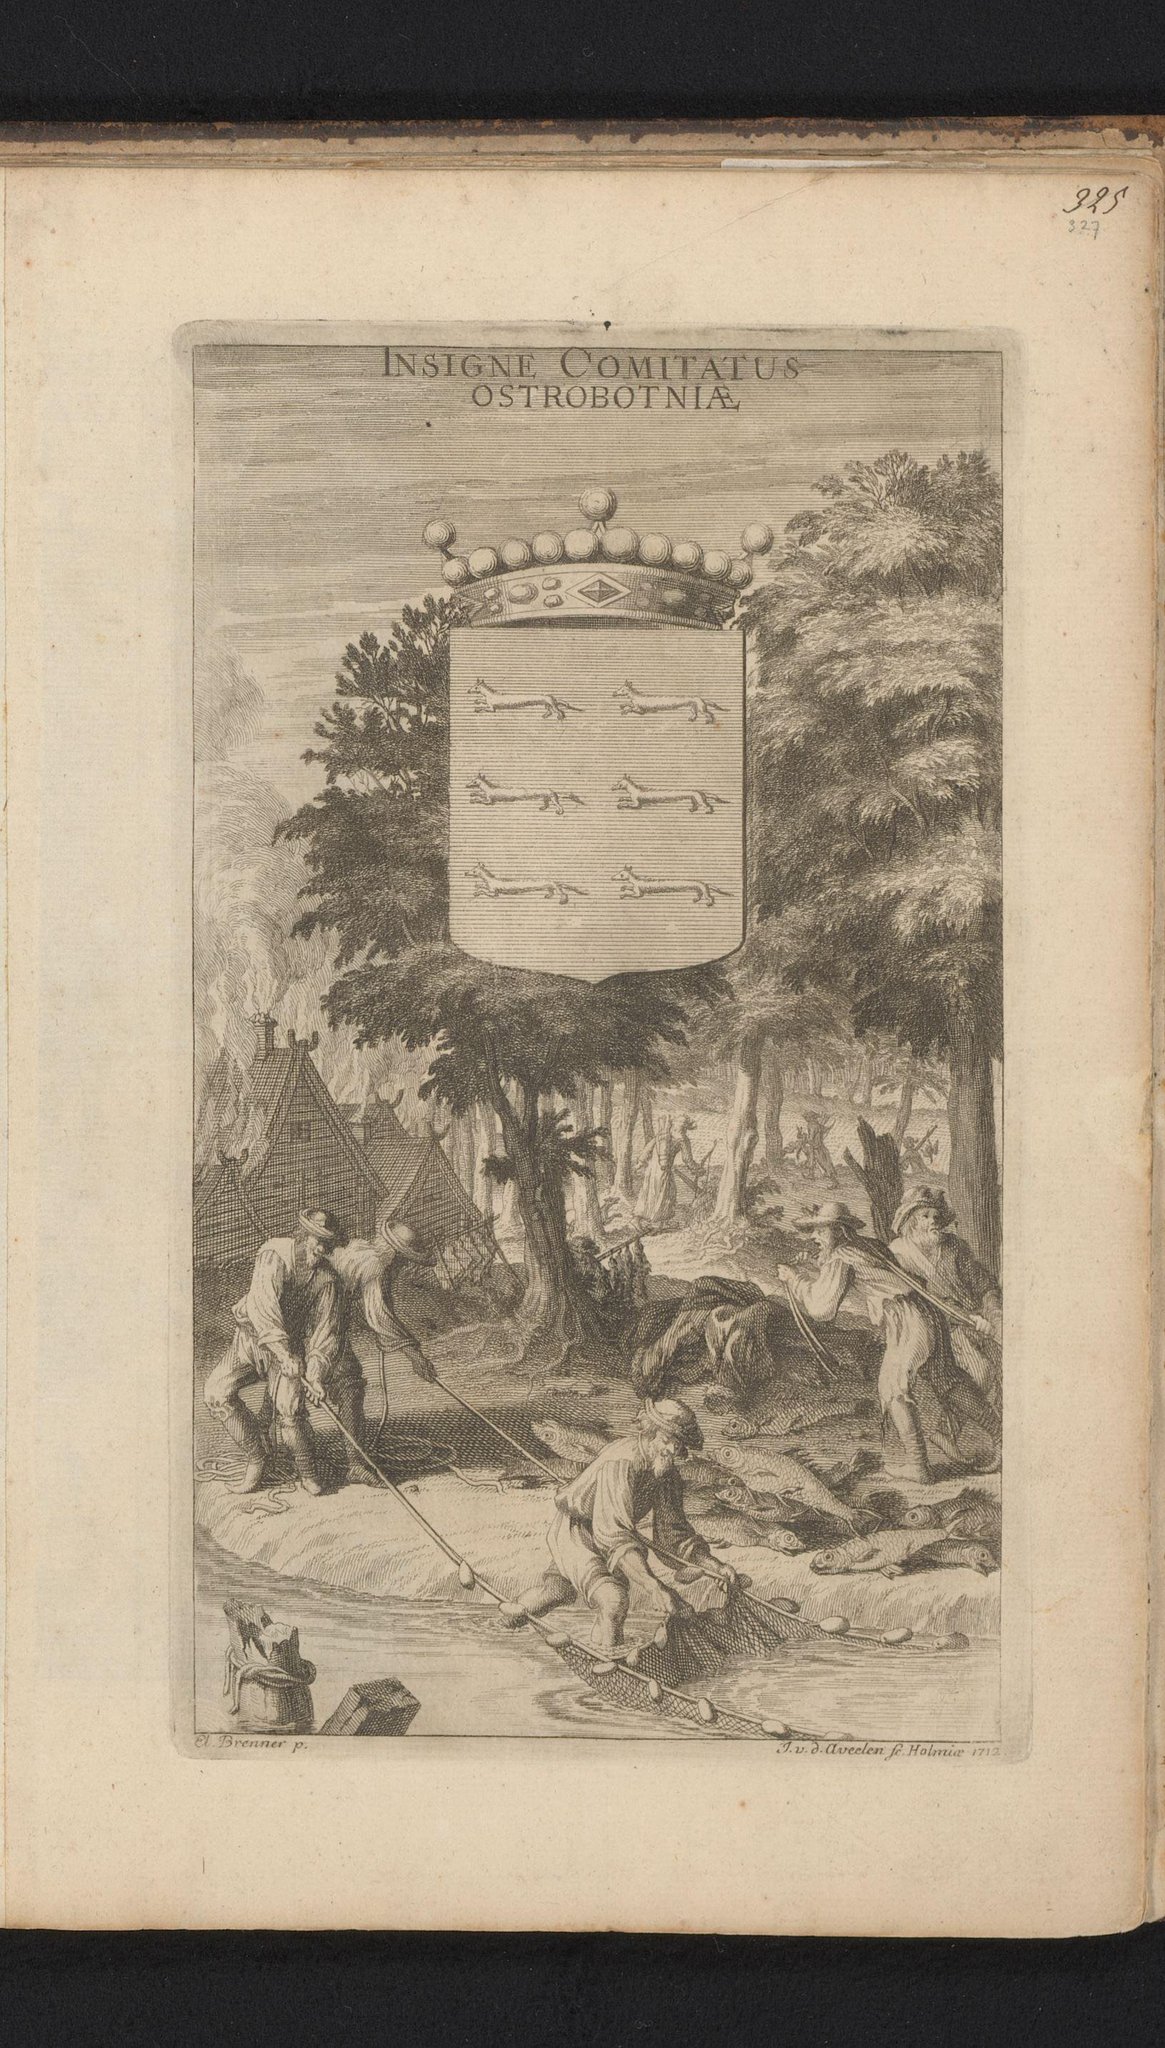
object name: album leaf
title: Insigne Comitatus Ostrobotniae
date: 1712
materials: paper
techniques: etching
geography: stockholm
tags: coat of arms (as symbol of the state, etc.), landscapes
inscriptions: date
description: Kungliga Biblioteket, 'Suecia': http://www.kb.se/samlingarna/Kartor-bilder/Suecia-antiqua/ (geraadpleegd november 2016).